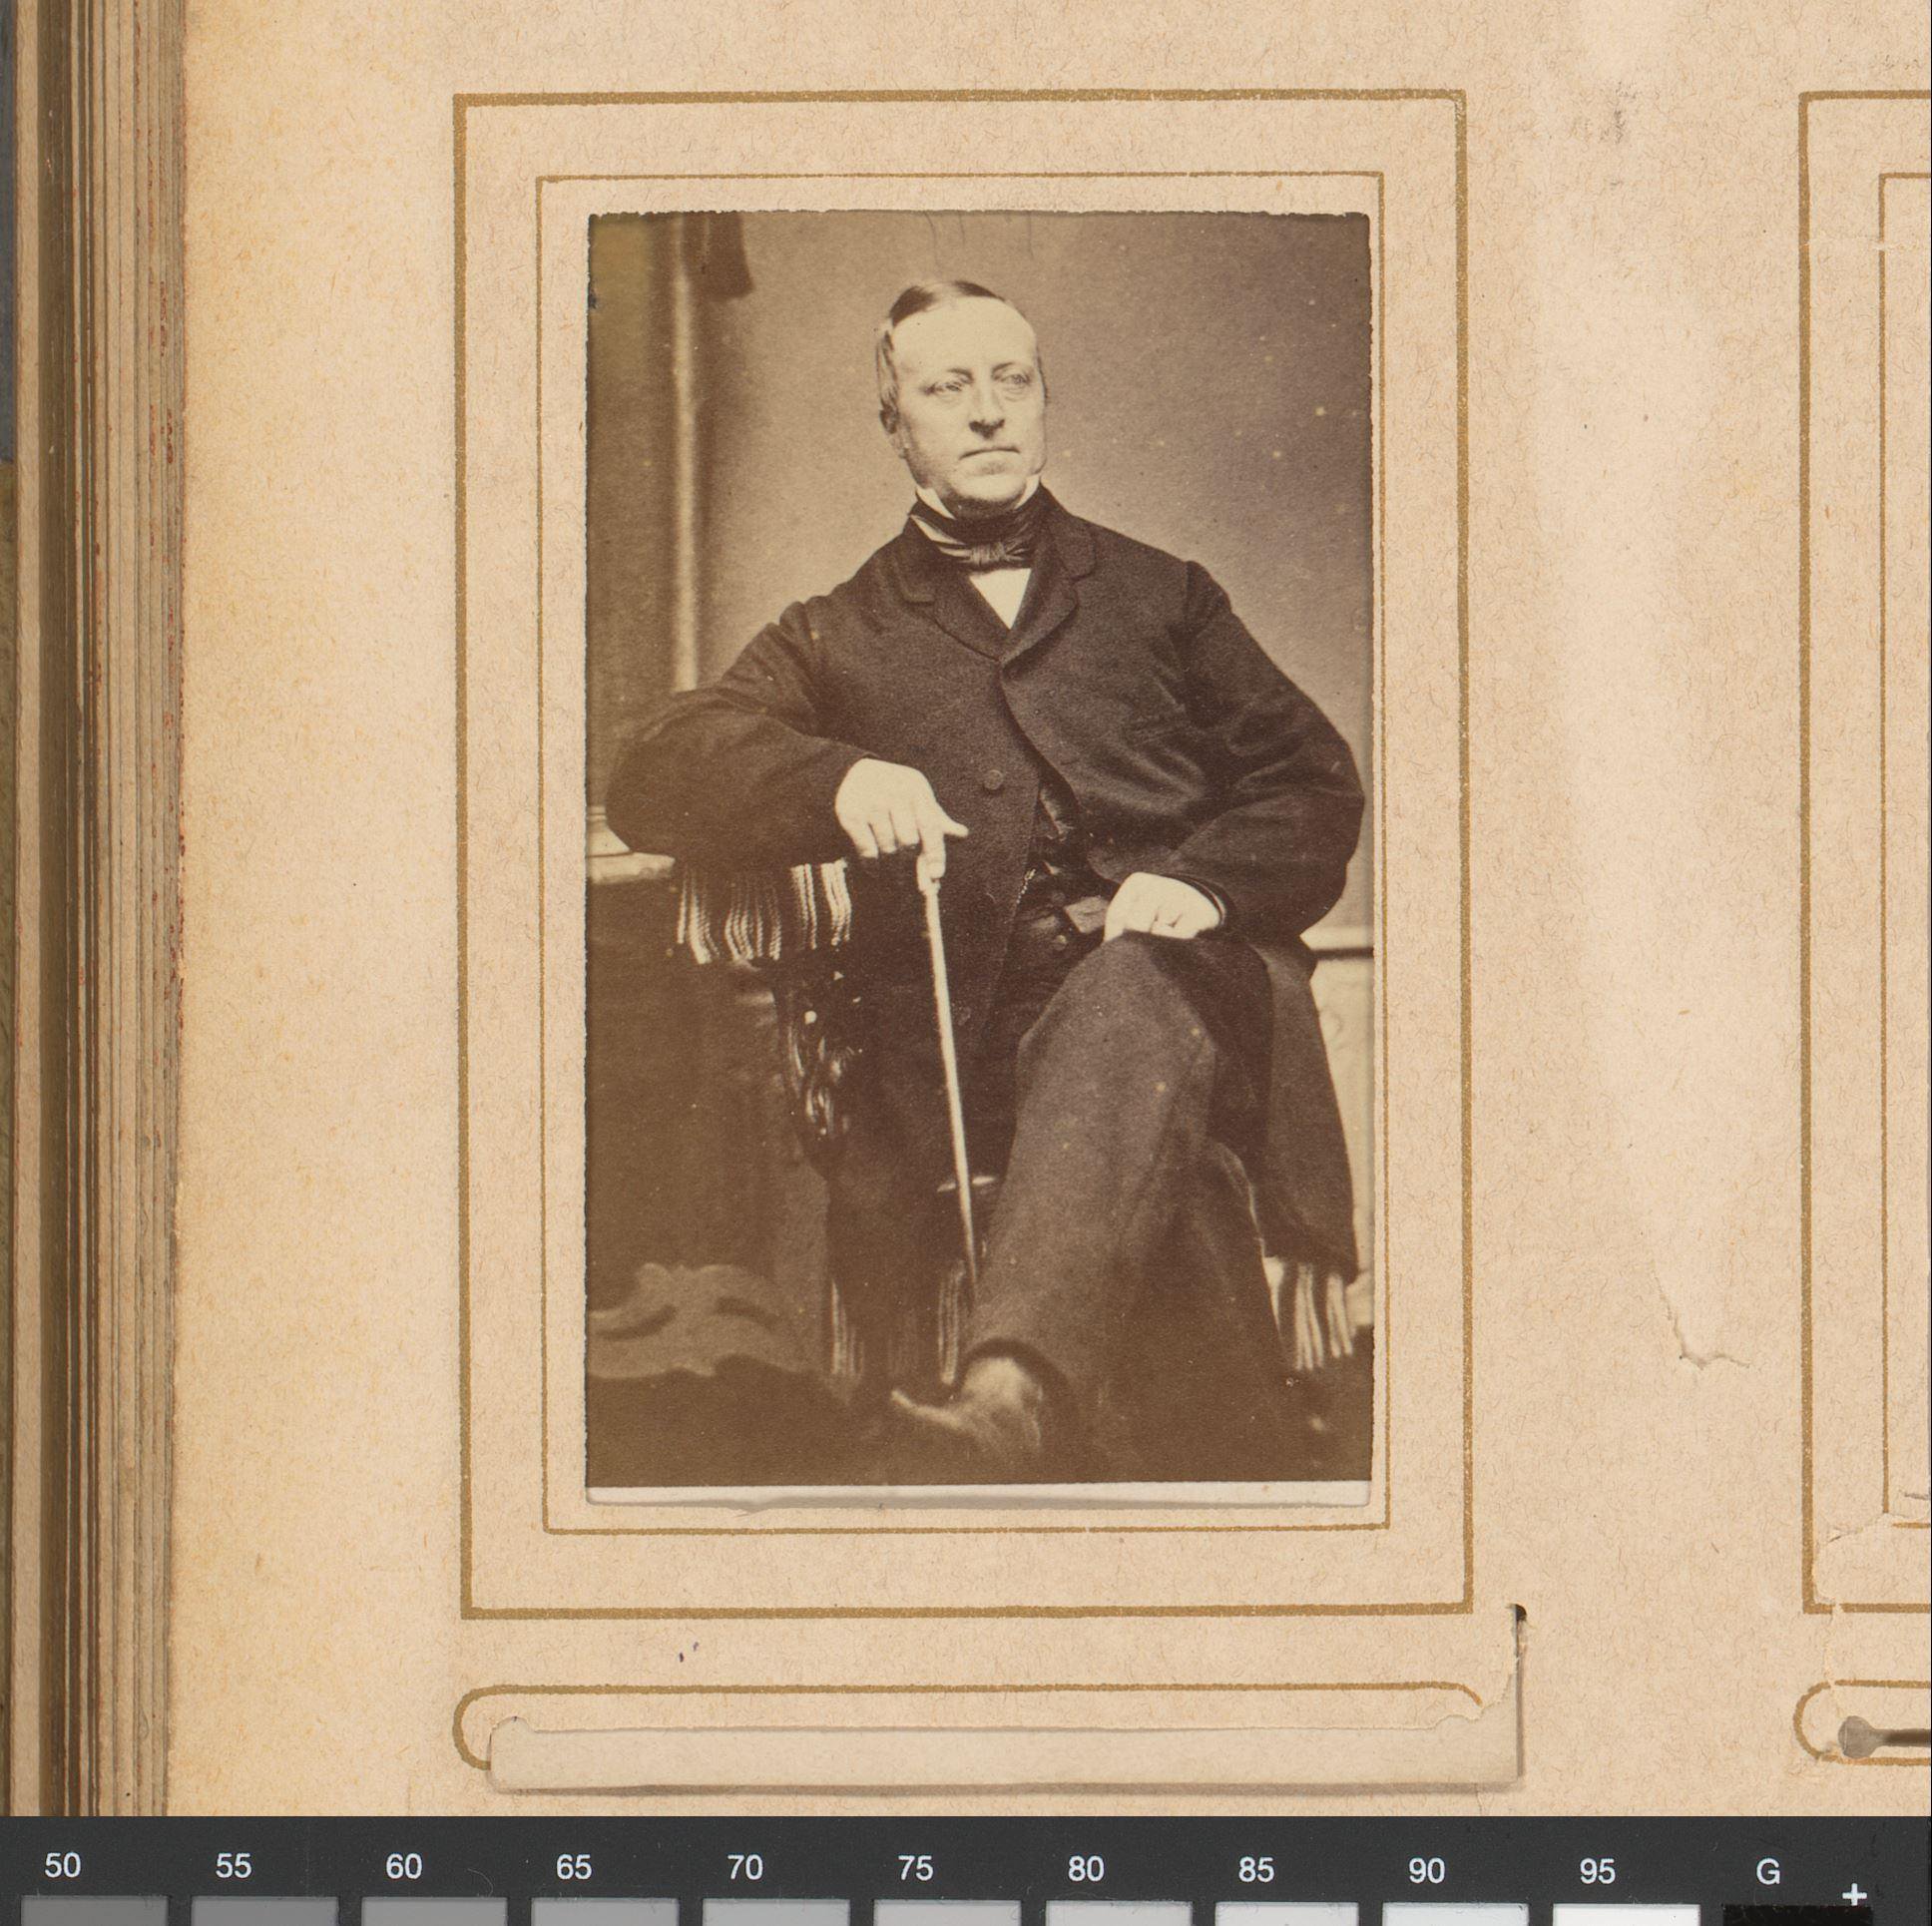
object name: album leaf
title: Portret van een zittende man met wandelstok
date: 1867-1870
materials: cardboard, photographic support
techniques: albumen print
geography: amsterdam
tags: sitting figure, walking-stick, staff, historical persons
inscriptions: inscription: ‘Photografisch Etablissement van S. van Caspel & Stapert/ Bloemgracht D.D. 43/ Amsterdam’